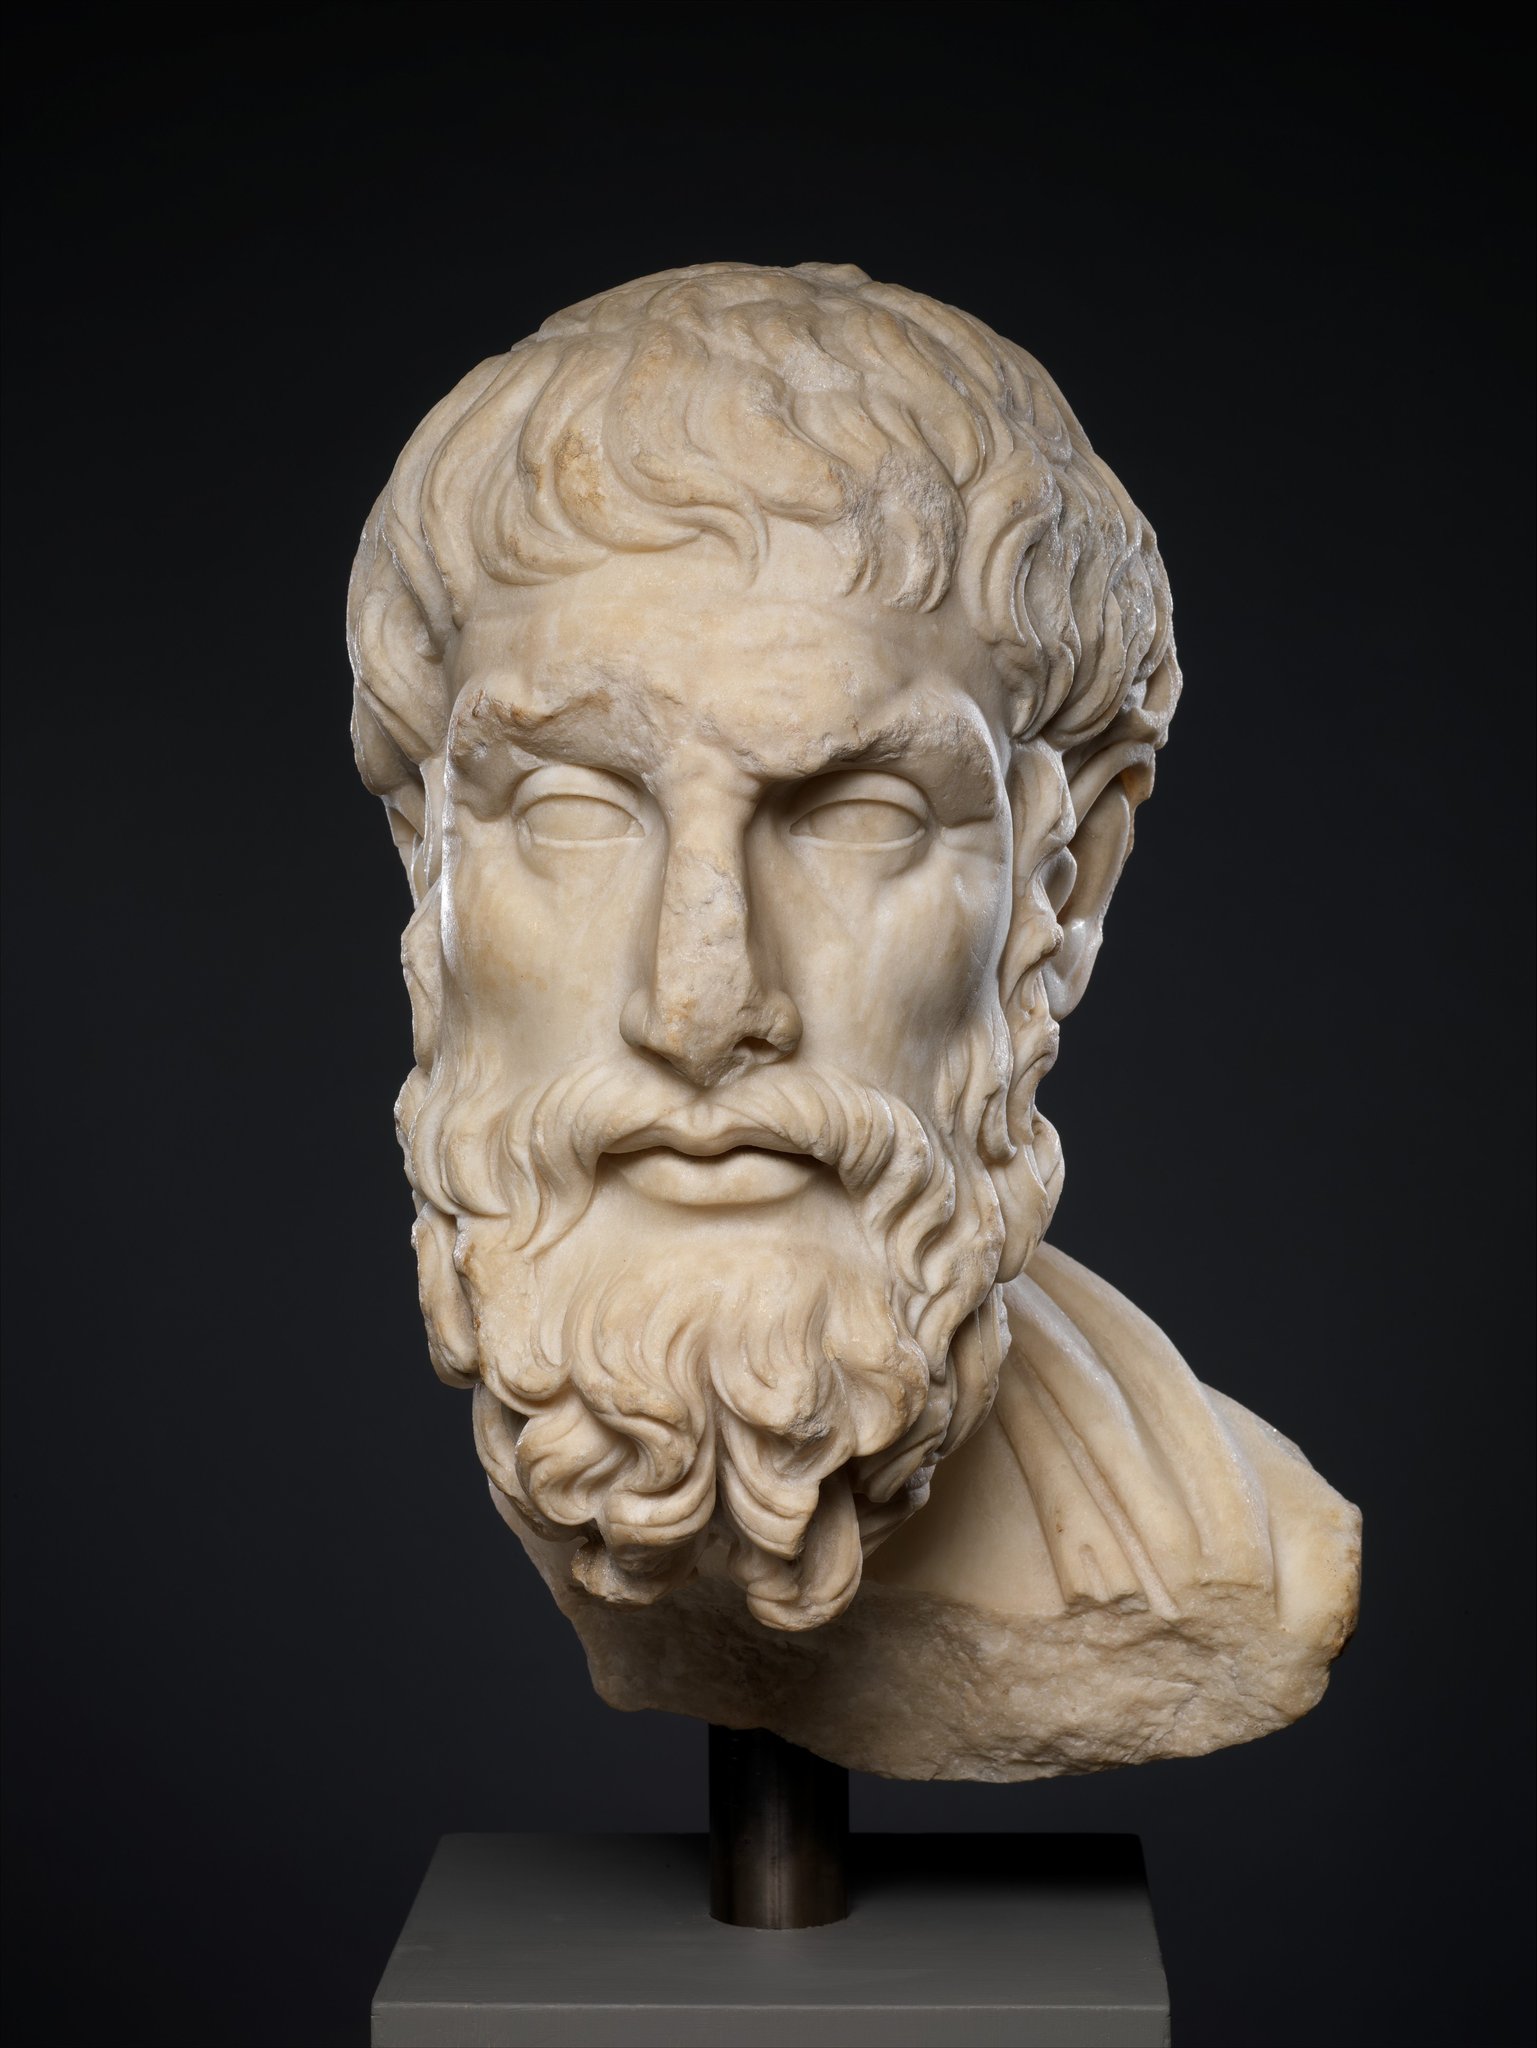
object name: portrait head of epicurus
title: Marble head of Epikouros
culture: roman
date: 101-200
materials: marble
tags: men,portraits